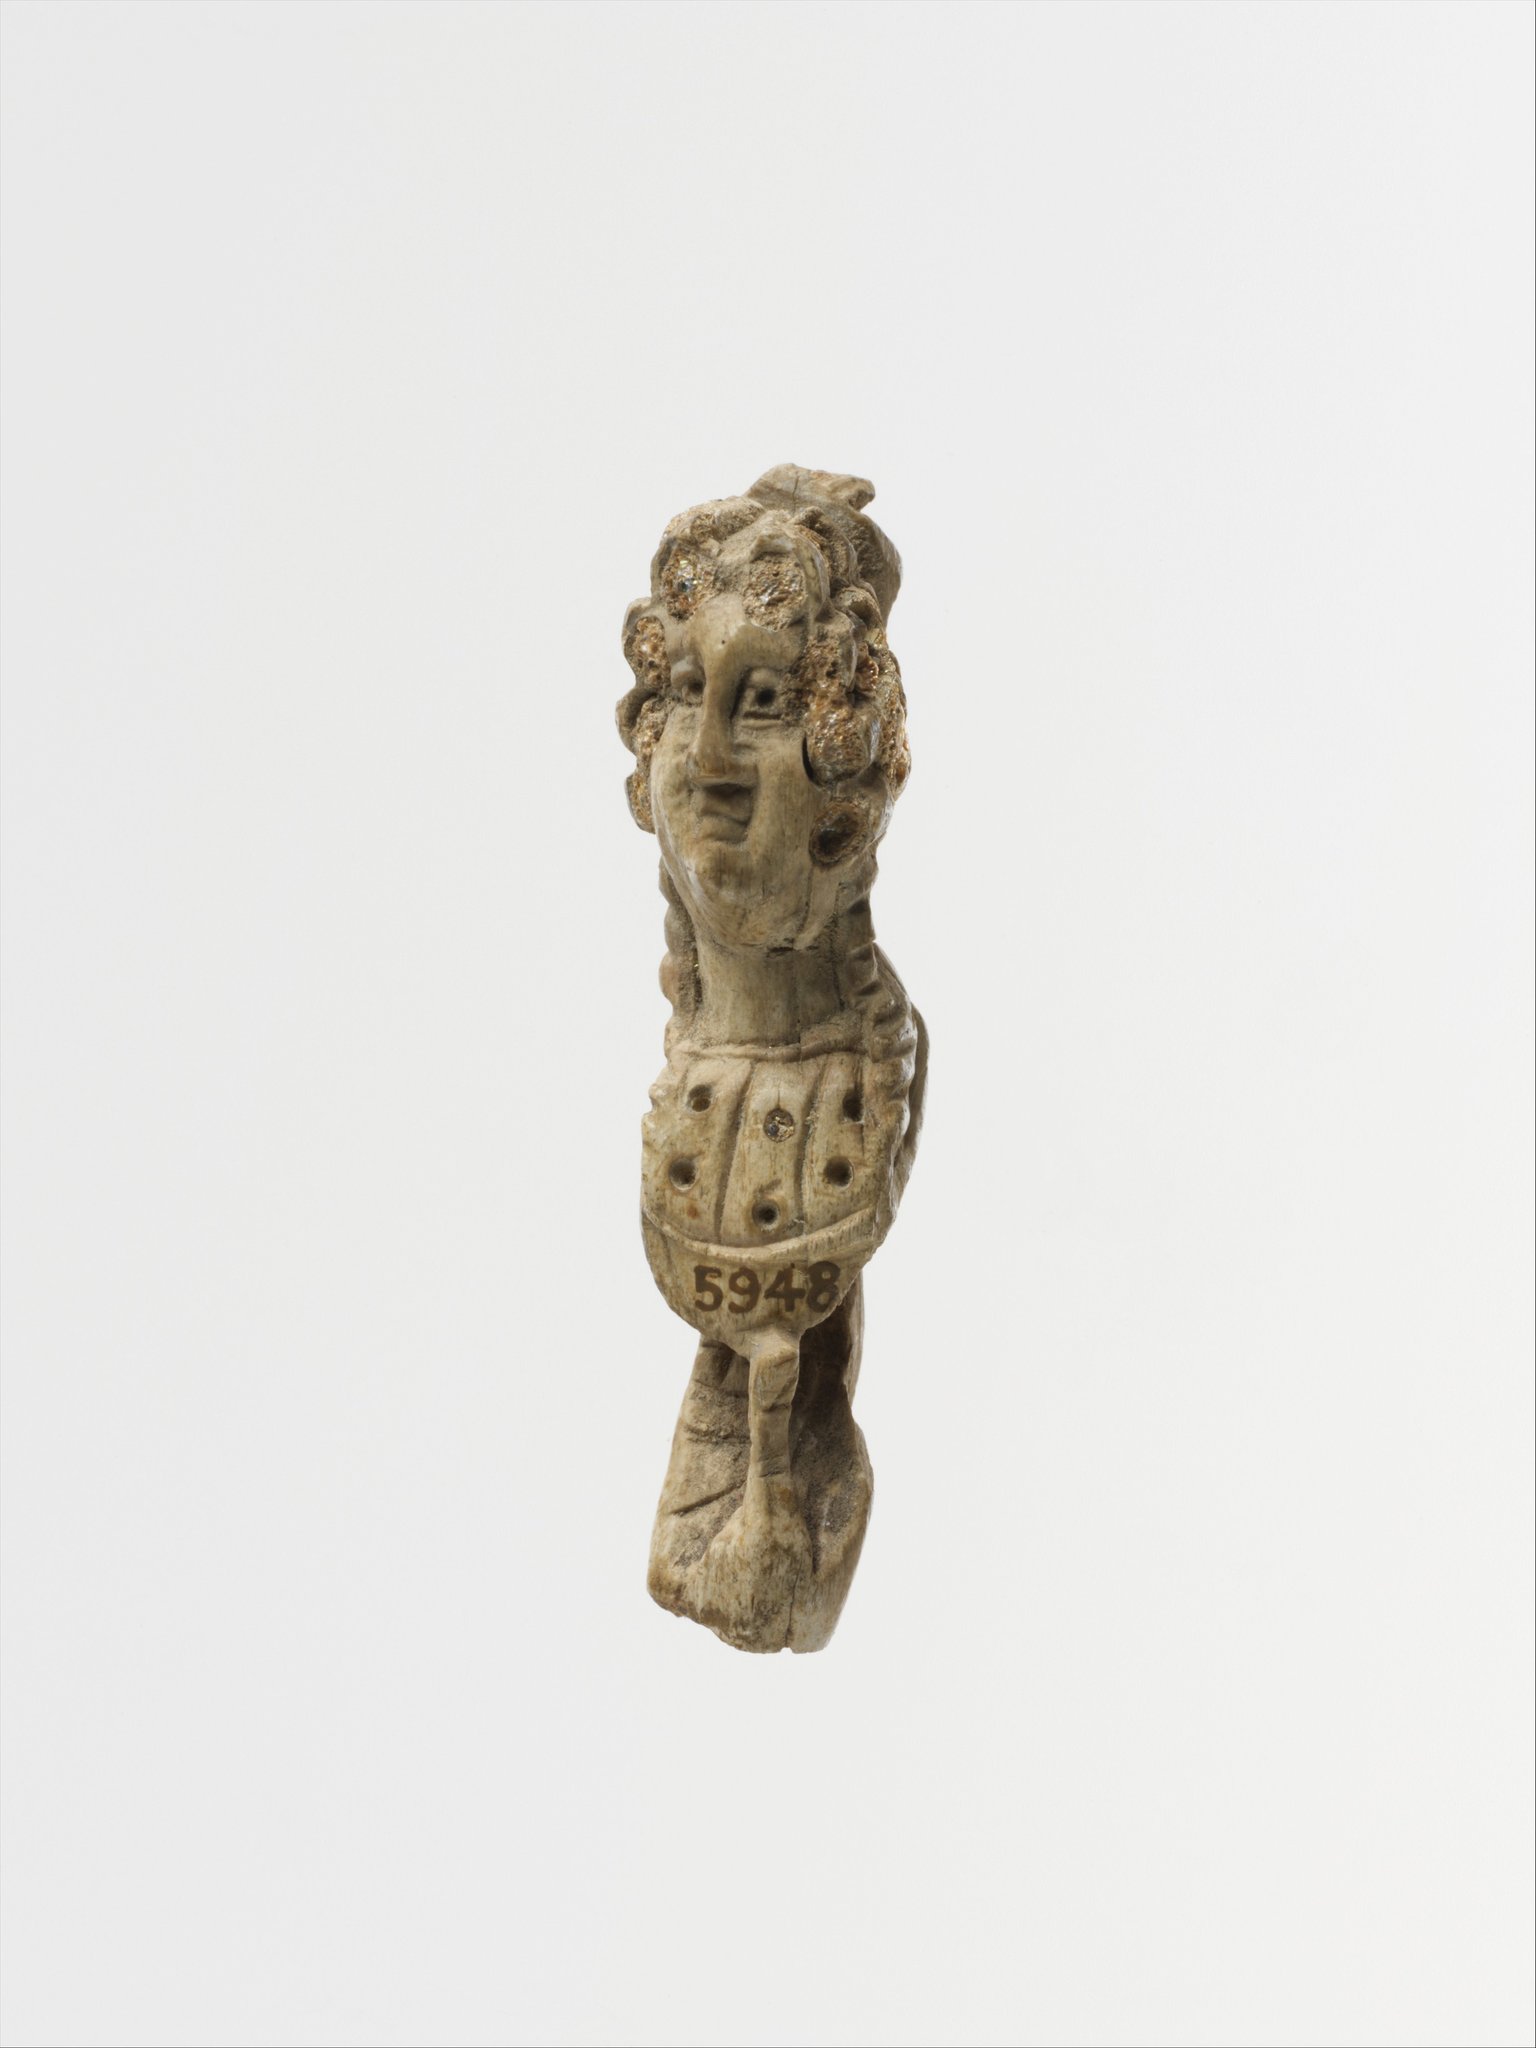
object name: pin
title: Bone pin head with female bust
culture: cypriot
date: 1-200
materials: bone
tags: women